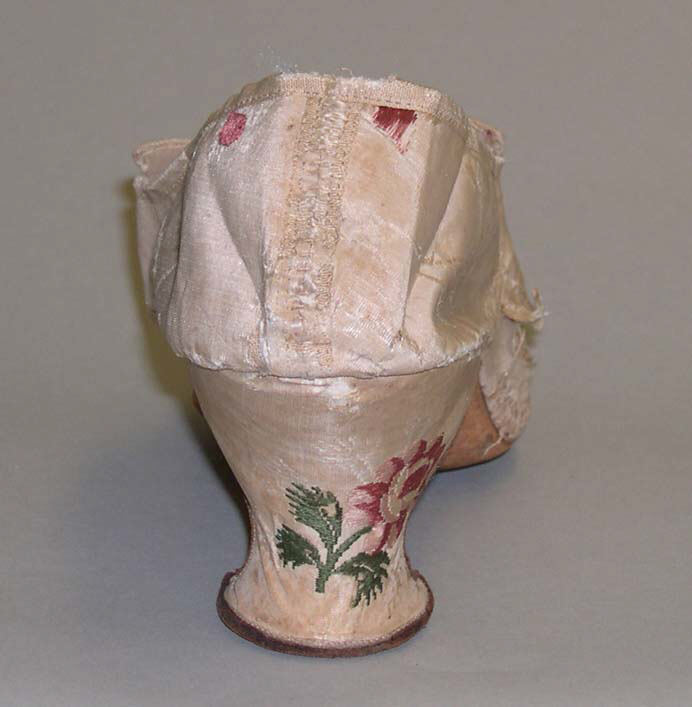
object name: shoe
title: Shoes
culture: british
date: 1760-1769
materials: leather, silk